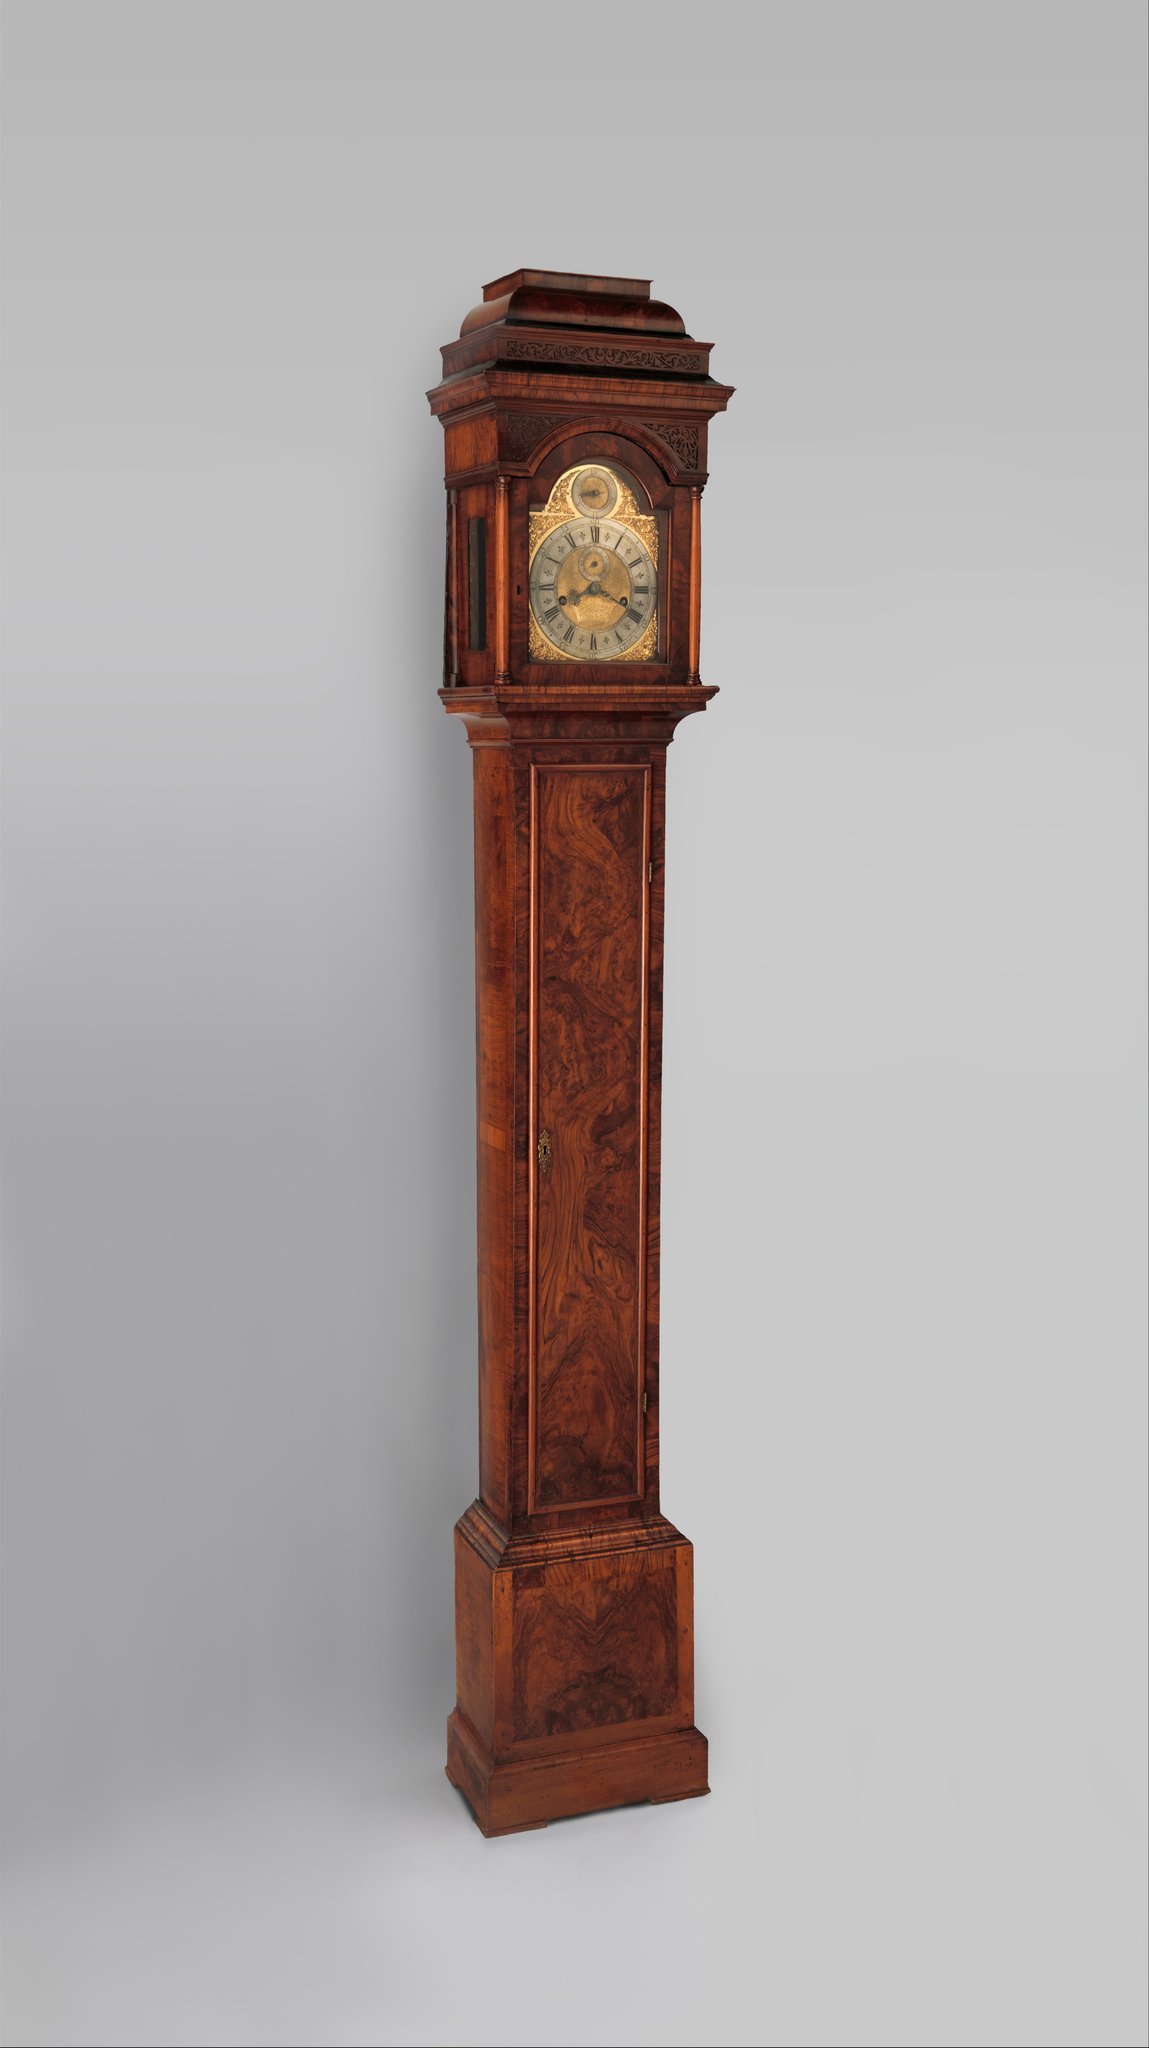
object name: miniature longcase clock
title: Miniature longcase clock with calendar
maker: daniel quare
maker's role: maker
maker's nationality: british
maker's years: 1647-1724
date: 1720-1725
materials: brass, gilt brass, wood, steel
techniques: gilding, silvered, veneering